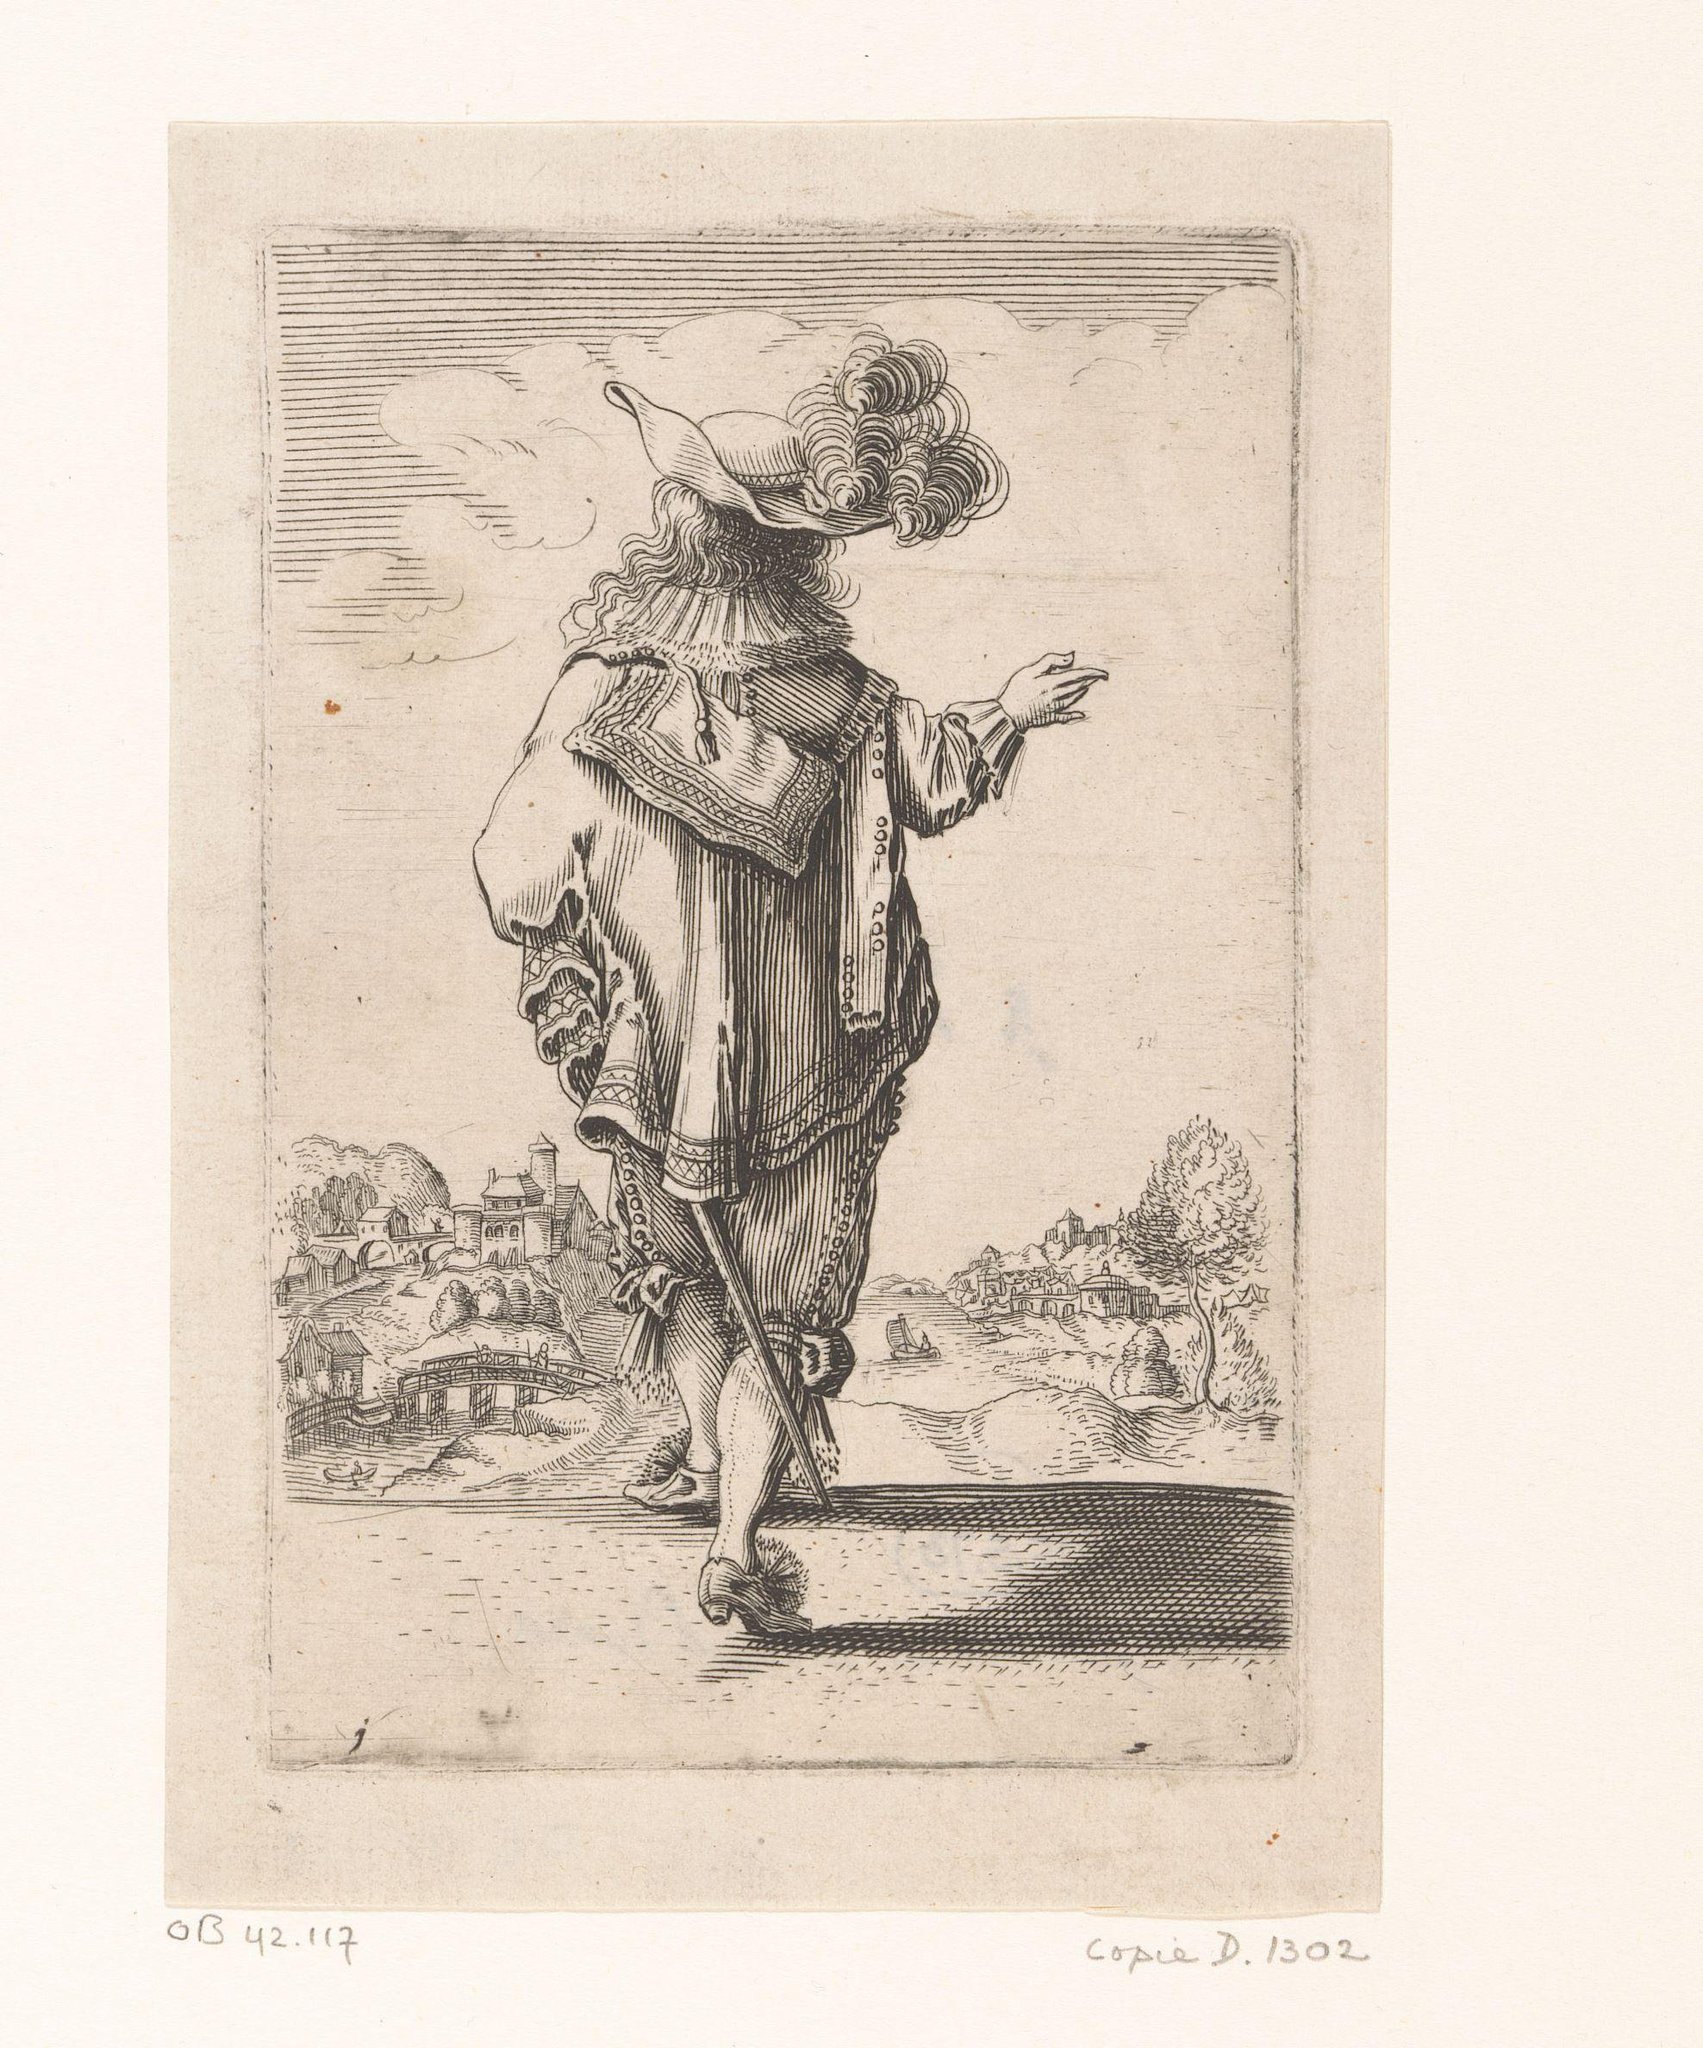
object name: costume print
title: Franse edelman, op de rug gezien, gekleed volgens de mode van ca. 1630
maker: Anonymous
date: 1629-1650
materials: paper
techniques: engraving, etching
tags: cape (+ men's clothes), head-gear: hat (+ men's clothes), styles of hairdress, neck-gear: collar (+ women's clothes), europeans (with name), shoes, sandals (+ men's clothes), clothes, costume (+ men's clothes), trousers, breeches, etc. (breeches) (+ men's clothes), hacking and thrusting weapons (foil), stockings, socks (+ men's clothes), head-gear: hat (+ feathers used for clothes)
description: Edelman, op de rug gezien, gekleed in korte schoudermantel over een wambuis met platte kraag. Kniebroek, schoenen met rozetten. Op zijn hoofd een hoed met brede rand en pluim, waaronder krullend haar, dat aan de linkerkant in een lange lok (moustache genaamd) op de schouder valt. Aan zijn linkerzijde een degen. De rechterarm uitgestrekt in een wijzend gebaar. Genummerd linksonder: i.